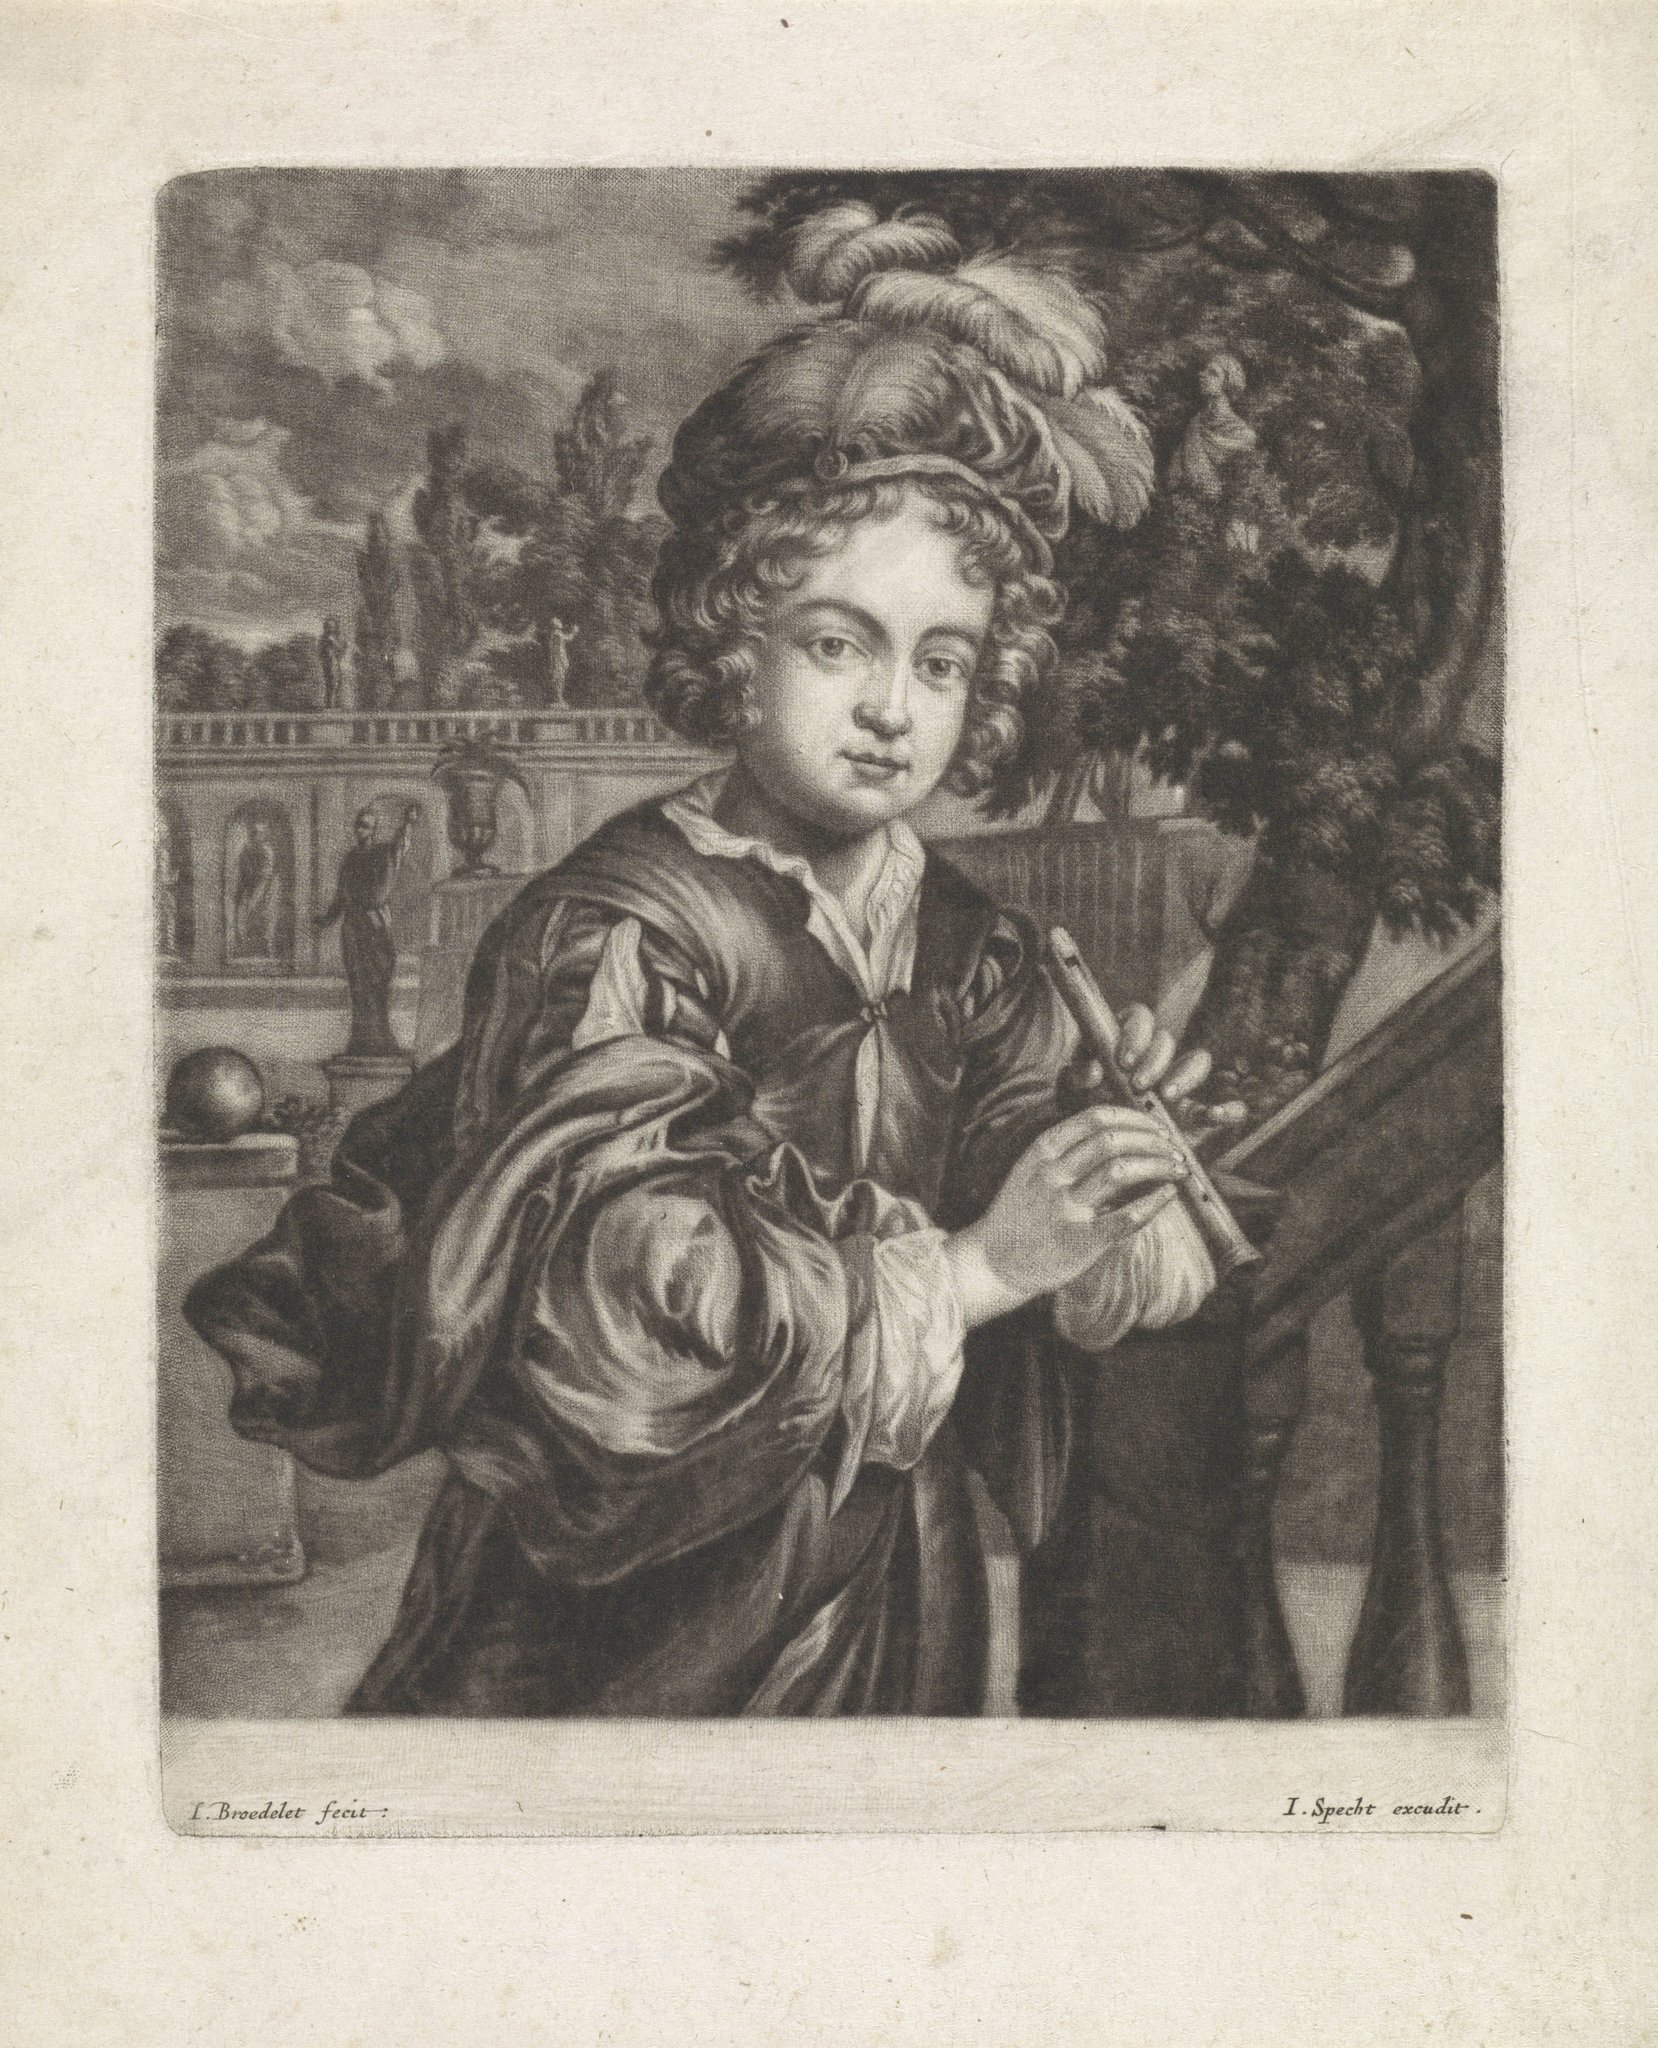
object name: print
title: Fluitspeler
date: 1690-1700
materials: paper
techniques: engraving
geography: utrecht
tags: head-gear: hat (+ men's clothes), flute, aulos, tibia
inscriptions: collector's mark: Lugt 2228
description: In een tuin met klassieke beelden staat een jongen met een fluit. Hij draagt een baret met veren.